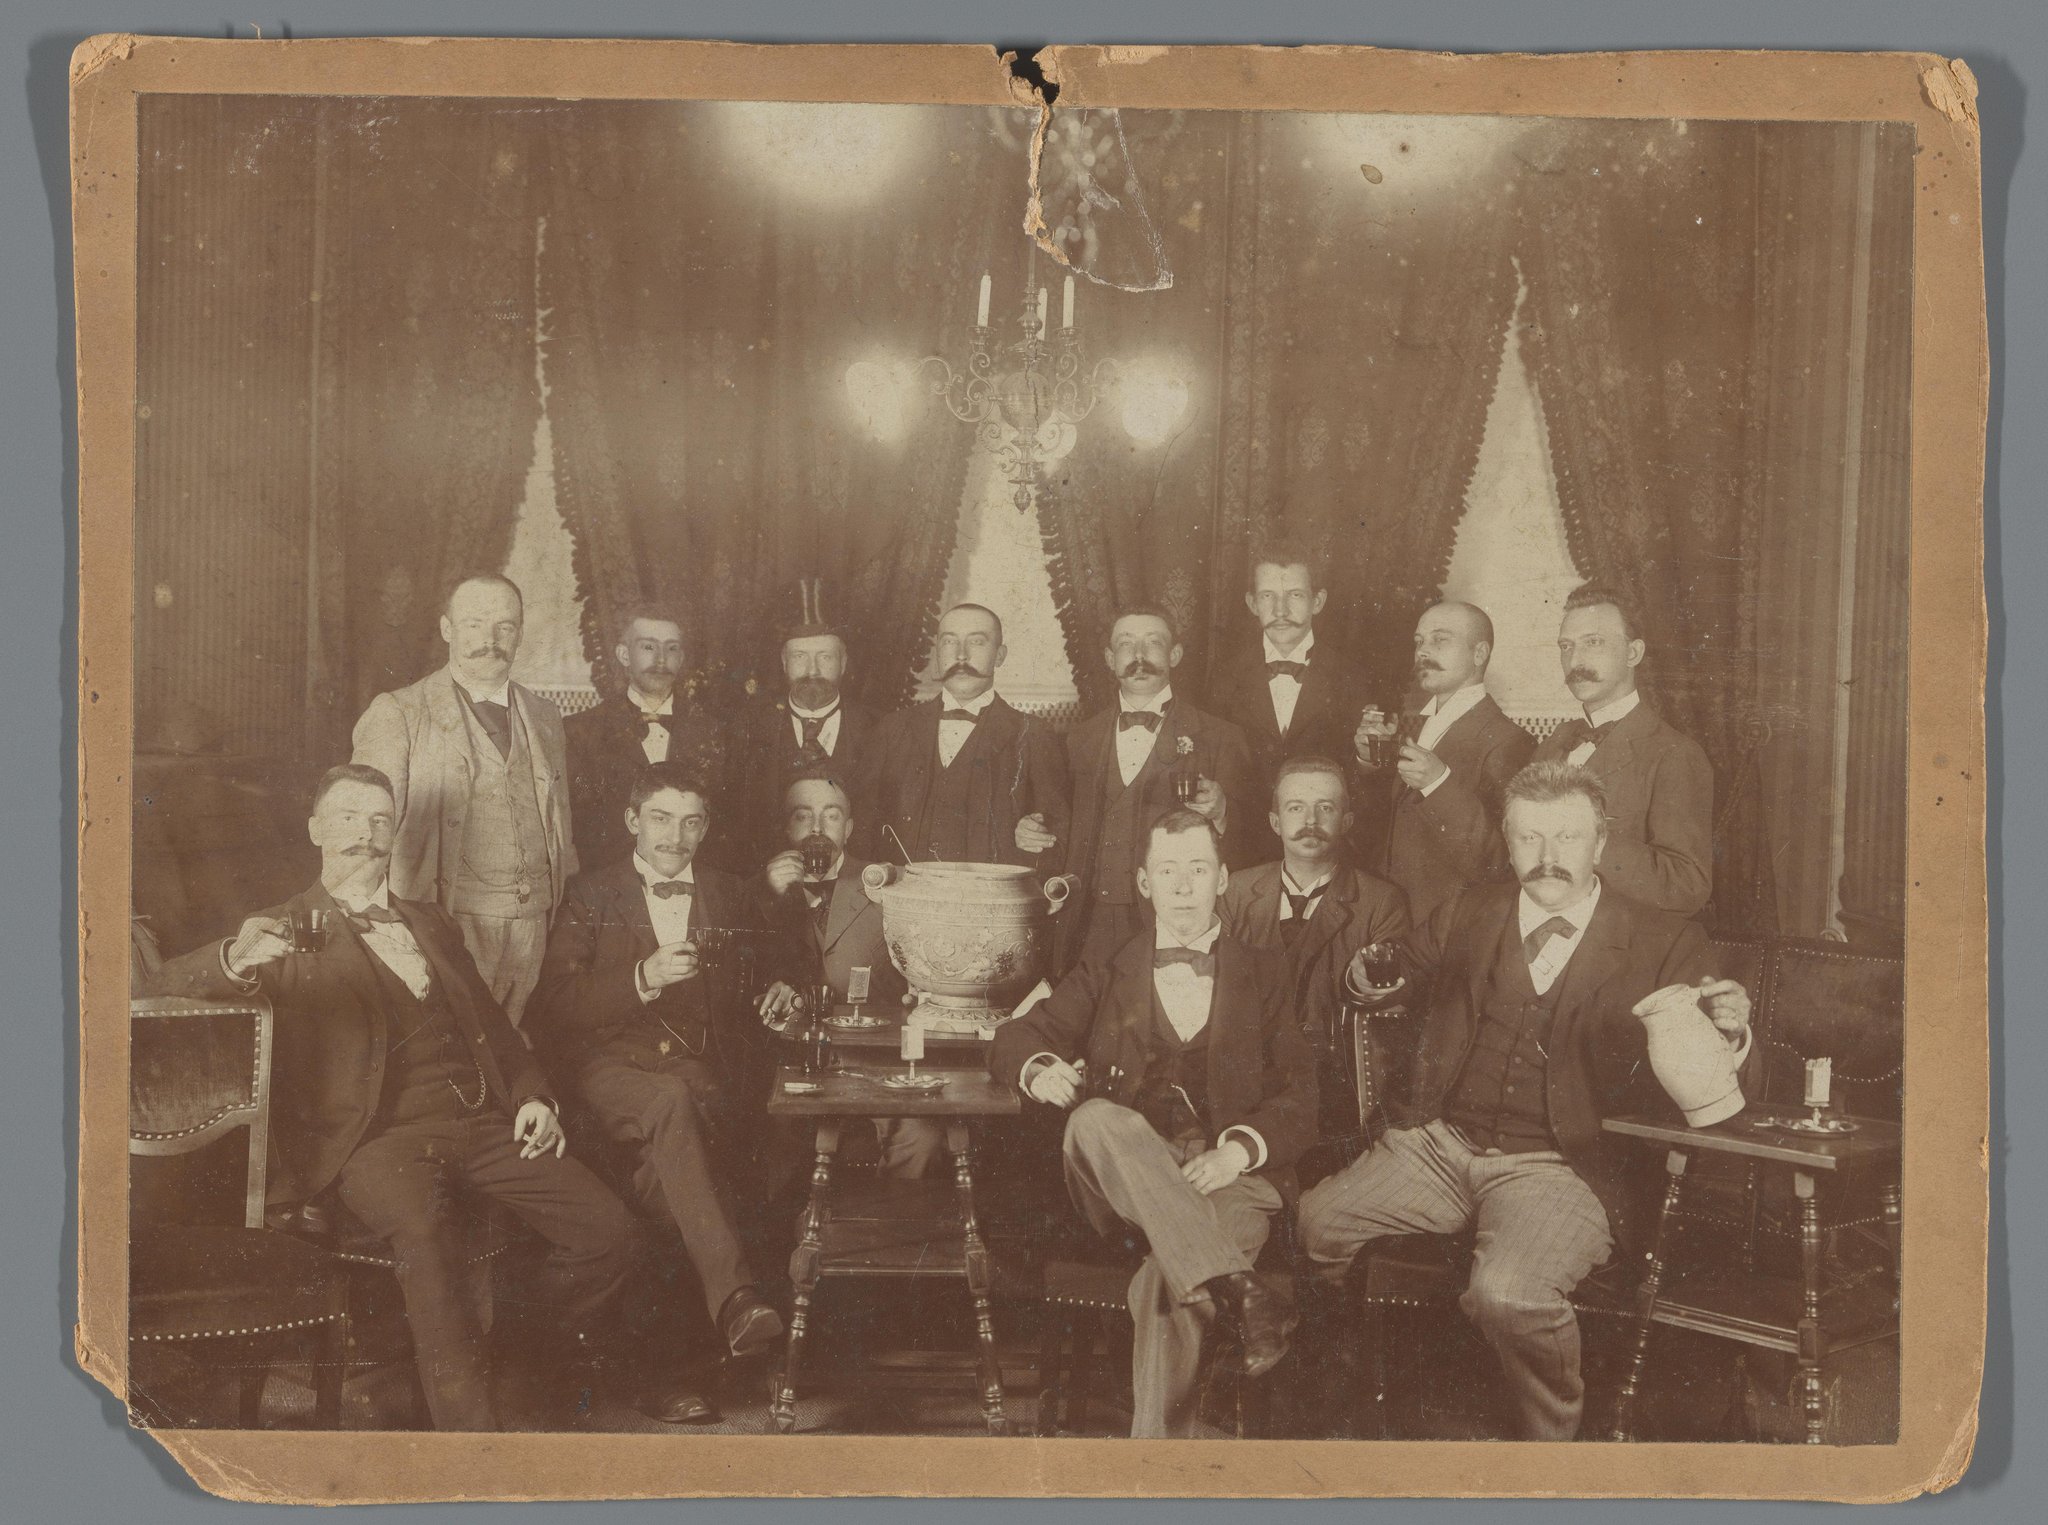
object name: photograph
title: Groepsportret van onbekende Nederlandse studenten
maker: Anonymous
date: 1900-1920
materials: paper, cardboard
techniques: collodion silver print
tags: student life, anonymous historical persons portrayed in a group, in a group-portrait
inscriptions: inscription: ‘Najaar 1912’